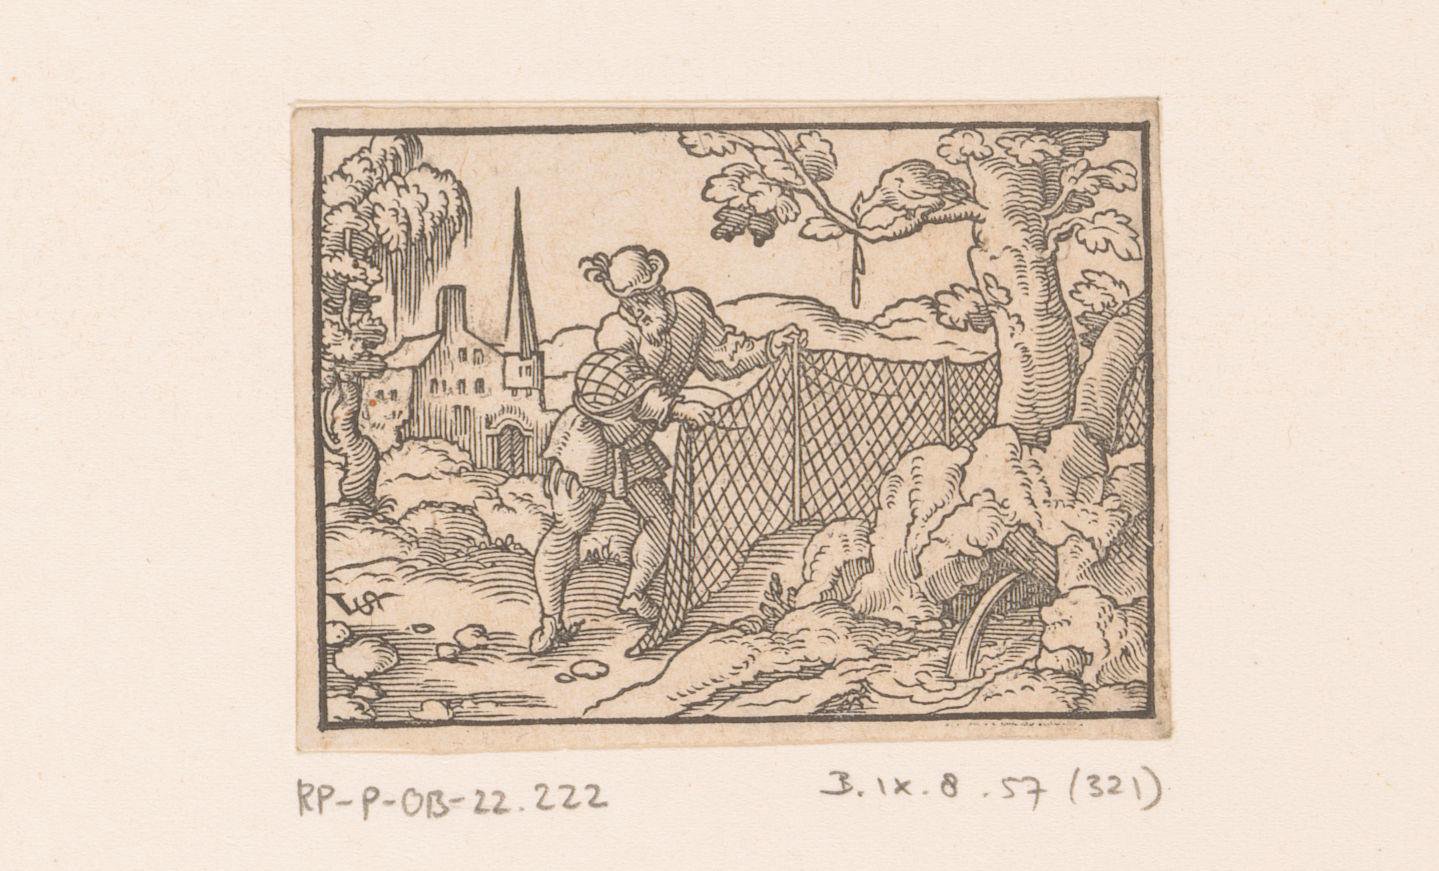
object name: print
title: Fabel van de vogelvanger en de leeuwerik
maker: virgilius solis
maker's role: draughtsman, print maker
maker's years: 1514-1562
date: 1566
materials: paper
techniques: woodcut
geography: nuremberg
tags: bird hunting, song-birds: lark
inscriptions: number: ‘184’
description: Illustratie bij de Fabels van Aesopus, onder meer gebruikt voor de publicatie: Posthius, Johann. Aesopi Phrygis Fabulae. Frankfurt am Main: Sigmund Feyerabend, Georg Rab en erven Weigand Han, 1566.